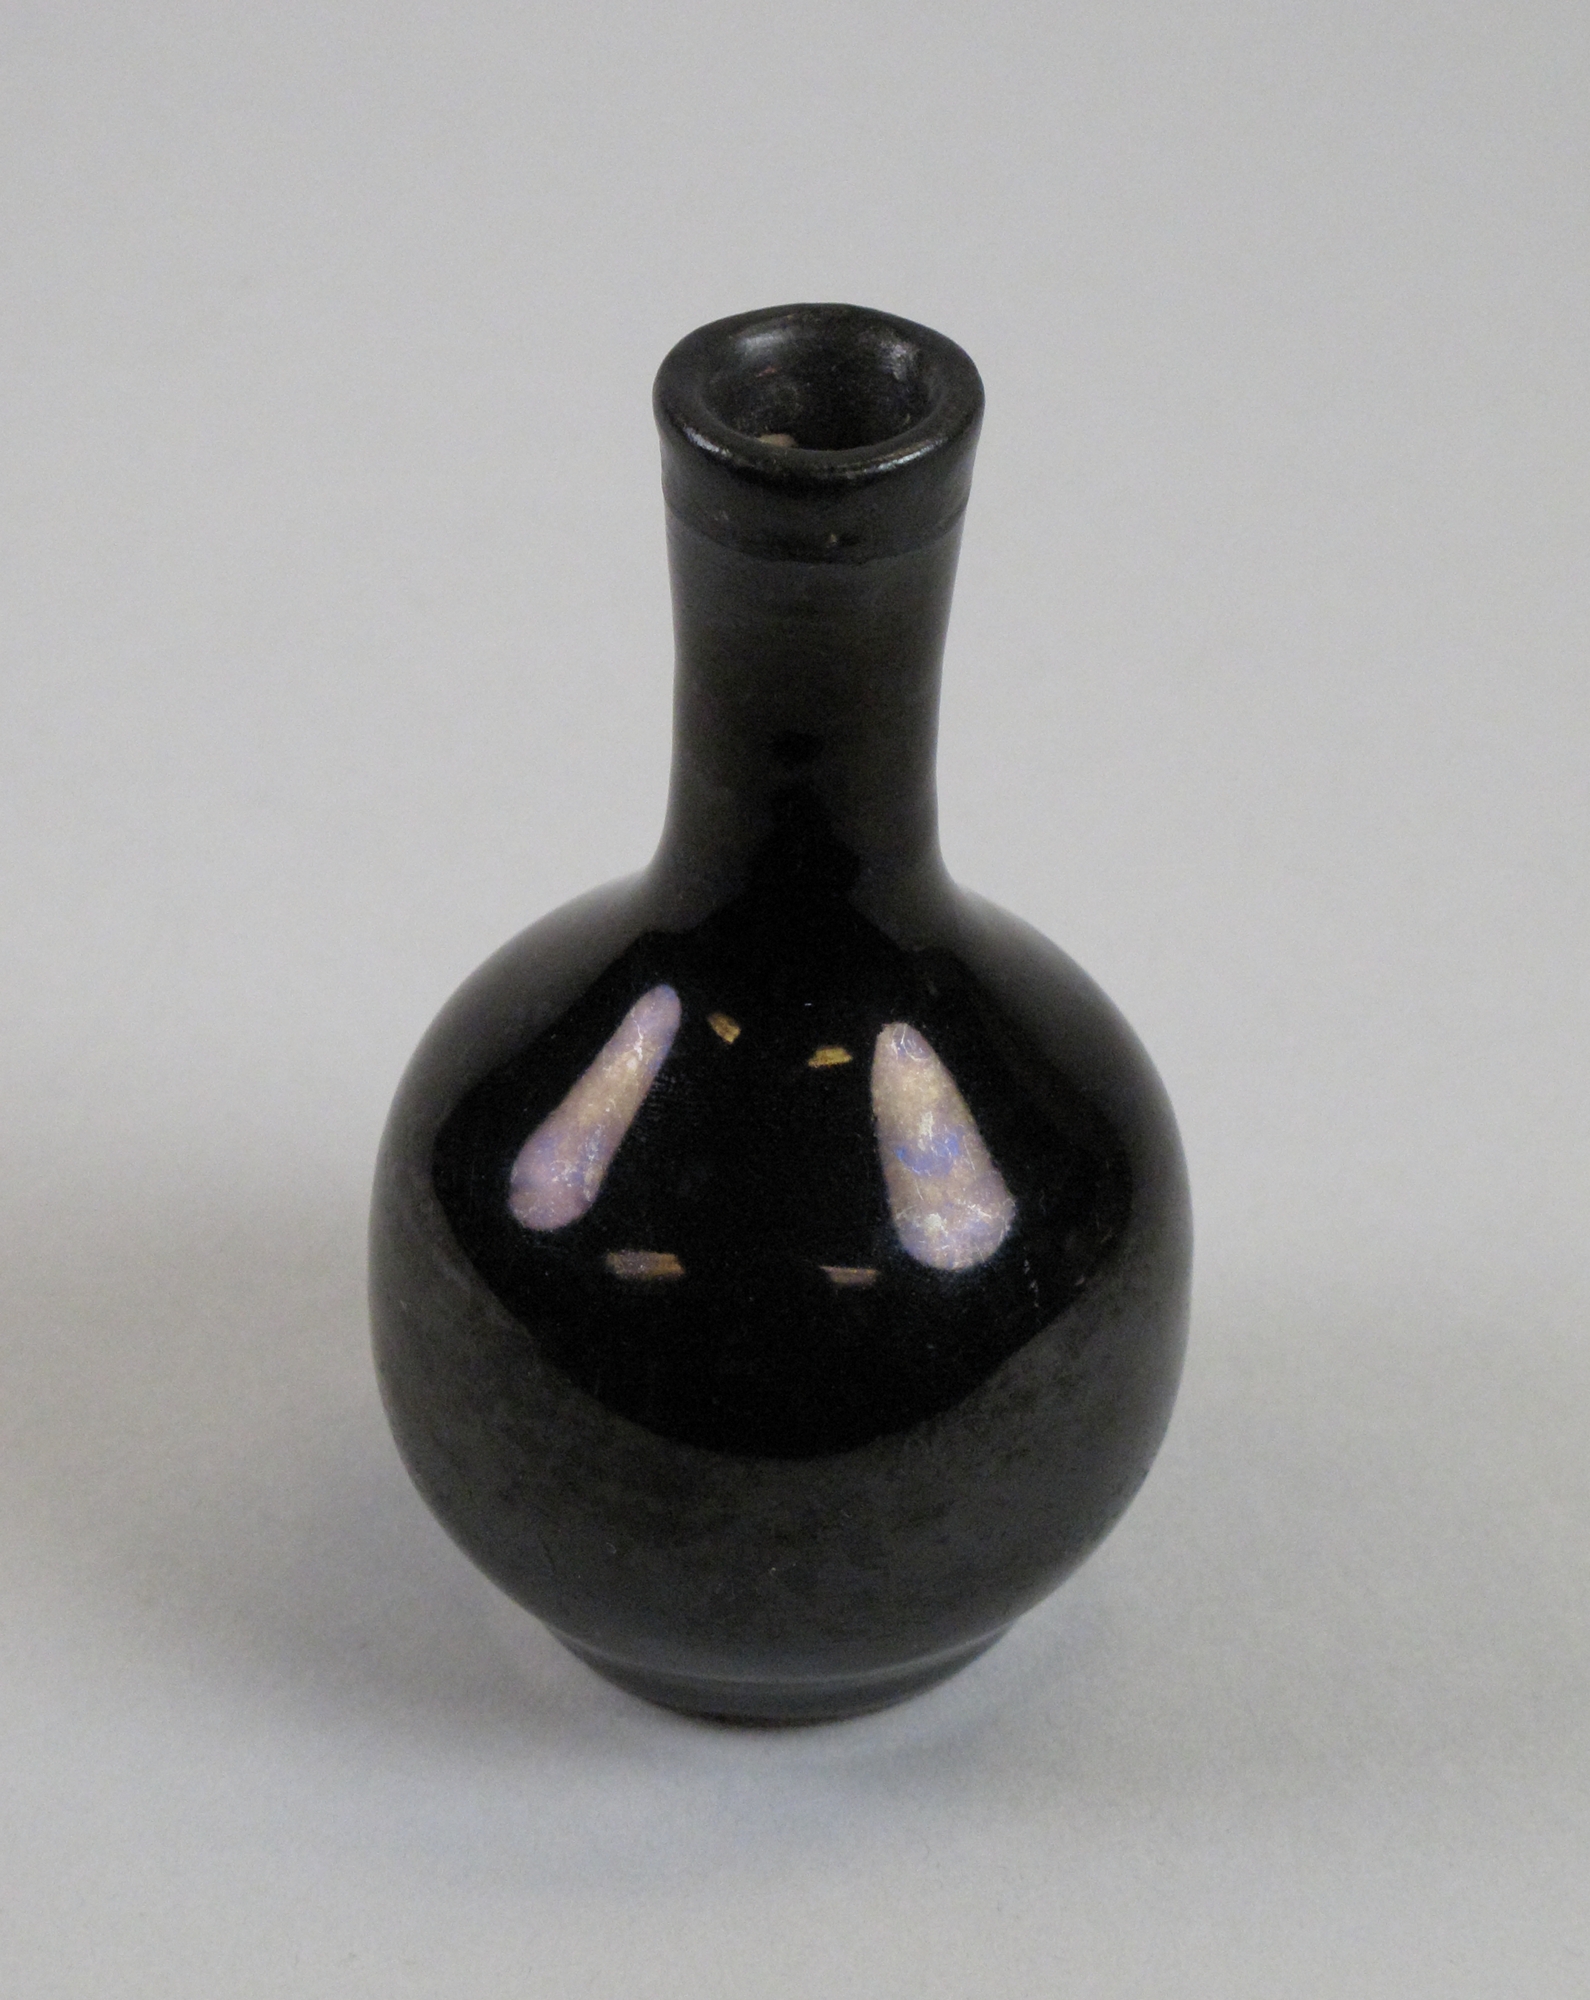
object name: vase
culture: chinese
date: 1801-1900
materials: glaze, porcelain